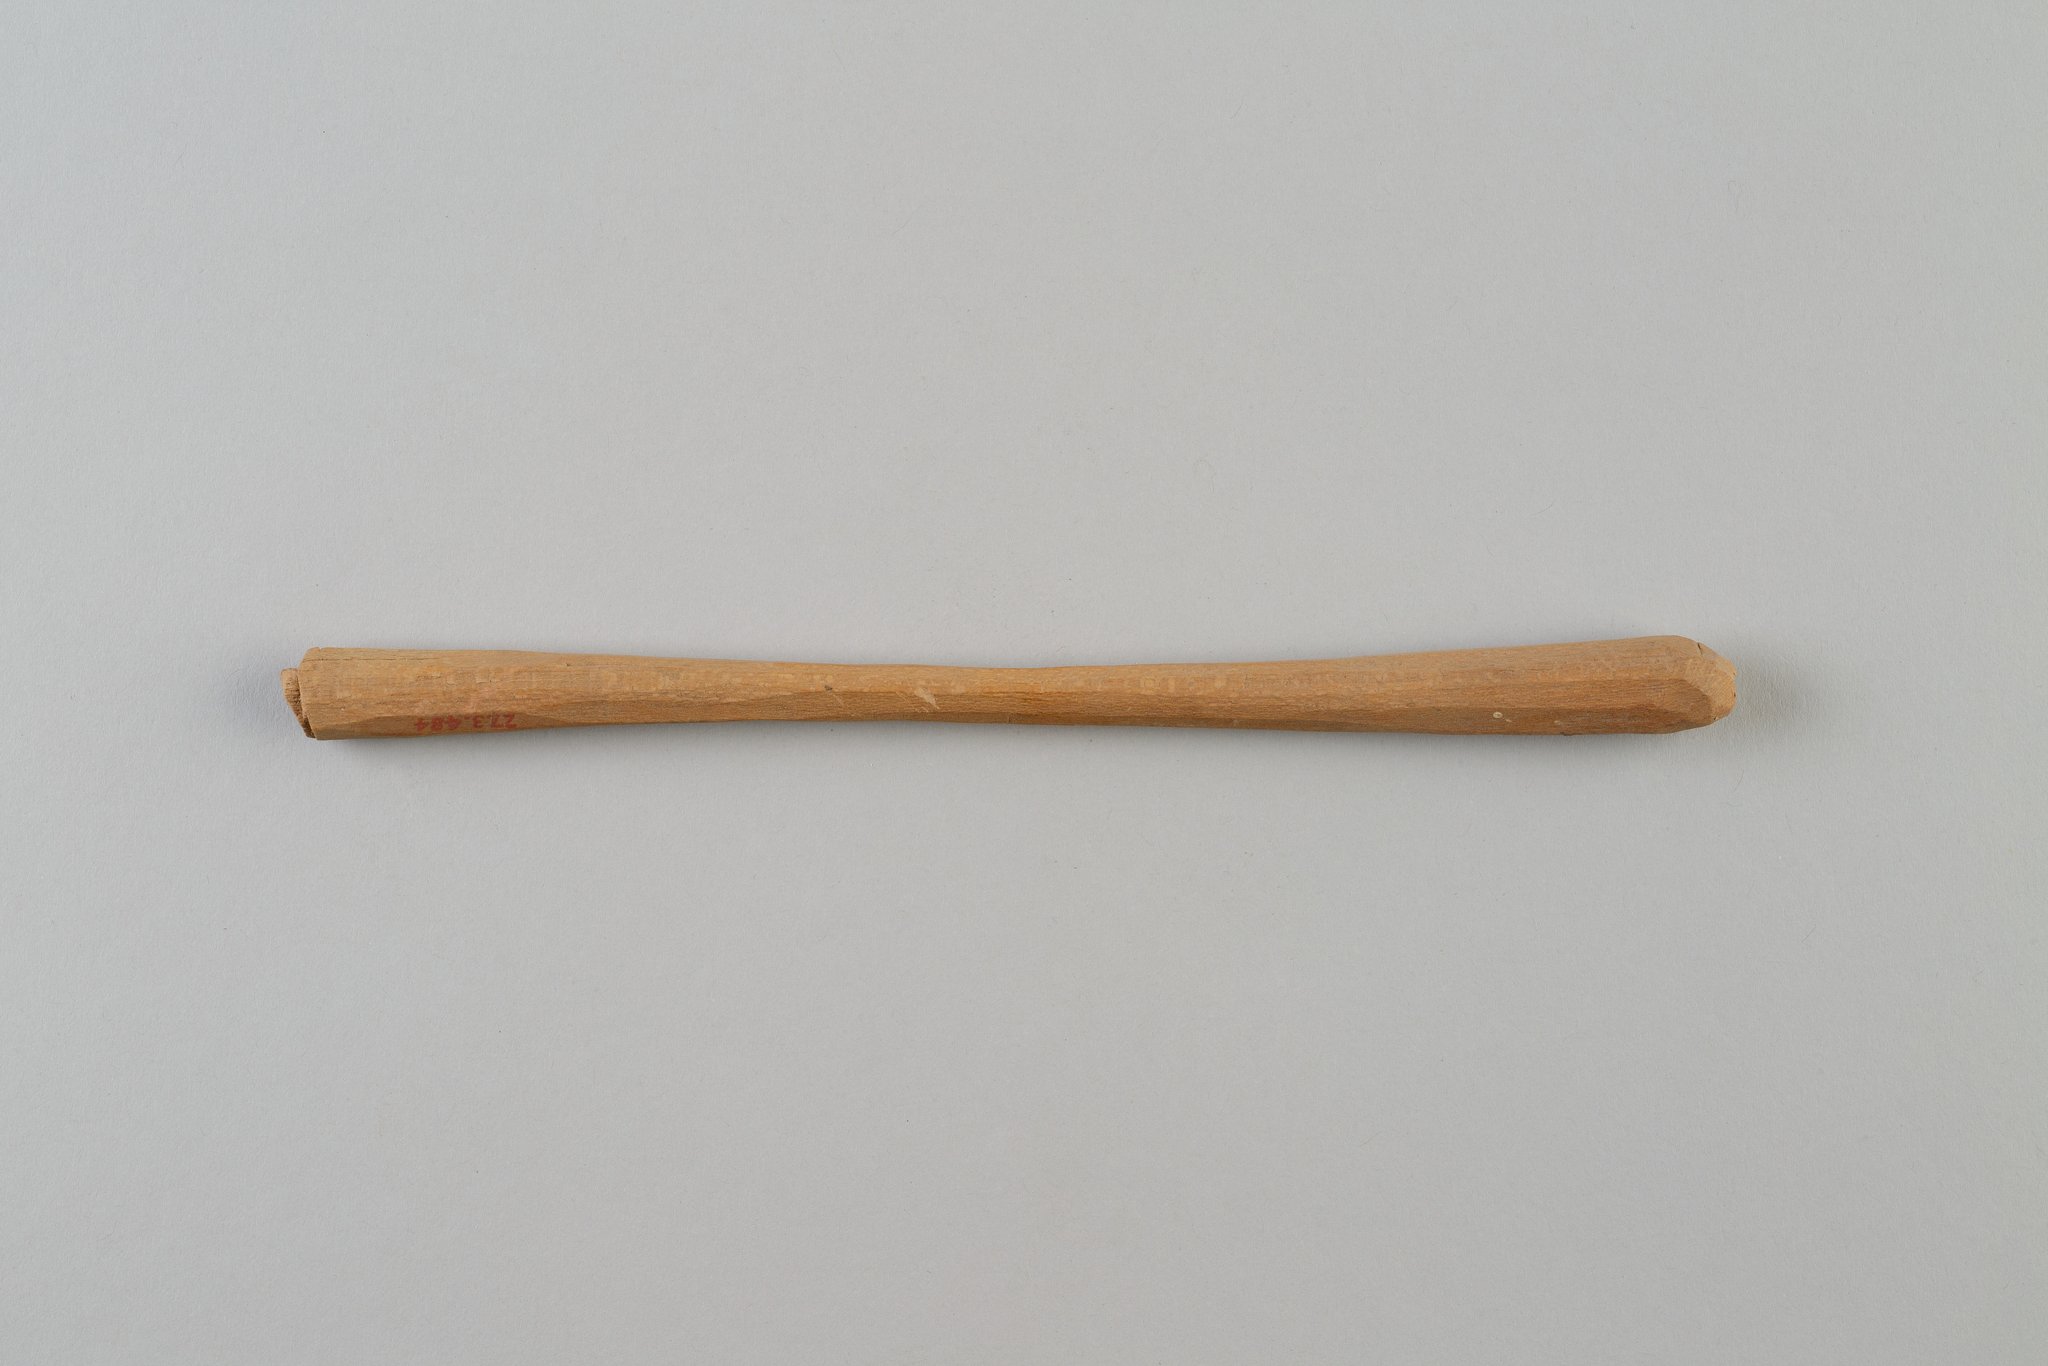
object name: lever, model, tool, senenmut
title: Model Tool from a Foundation Deposit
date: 1479-1458 BCE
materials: wood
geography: egypt